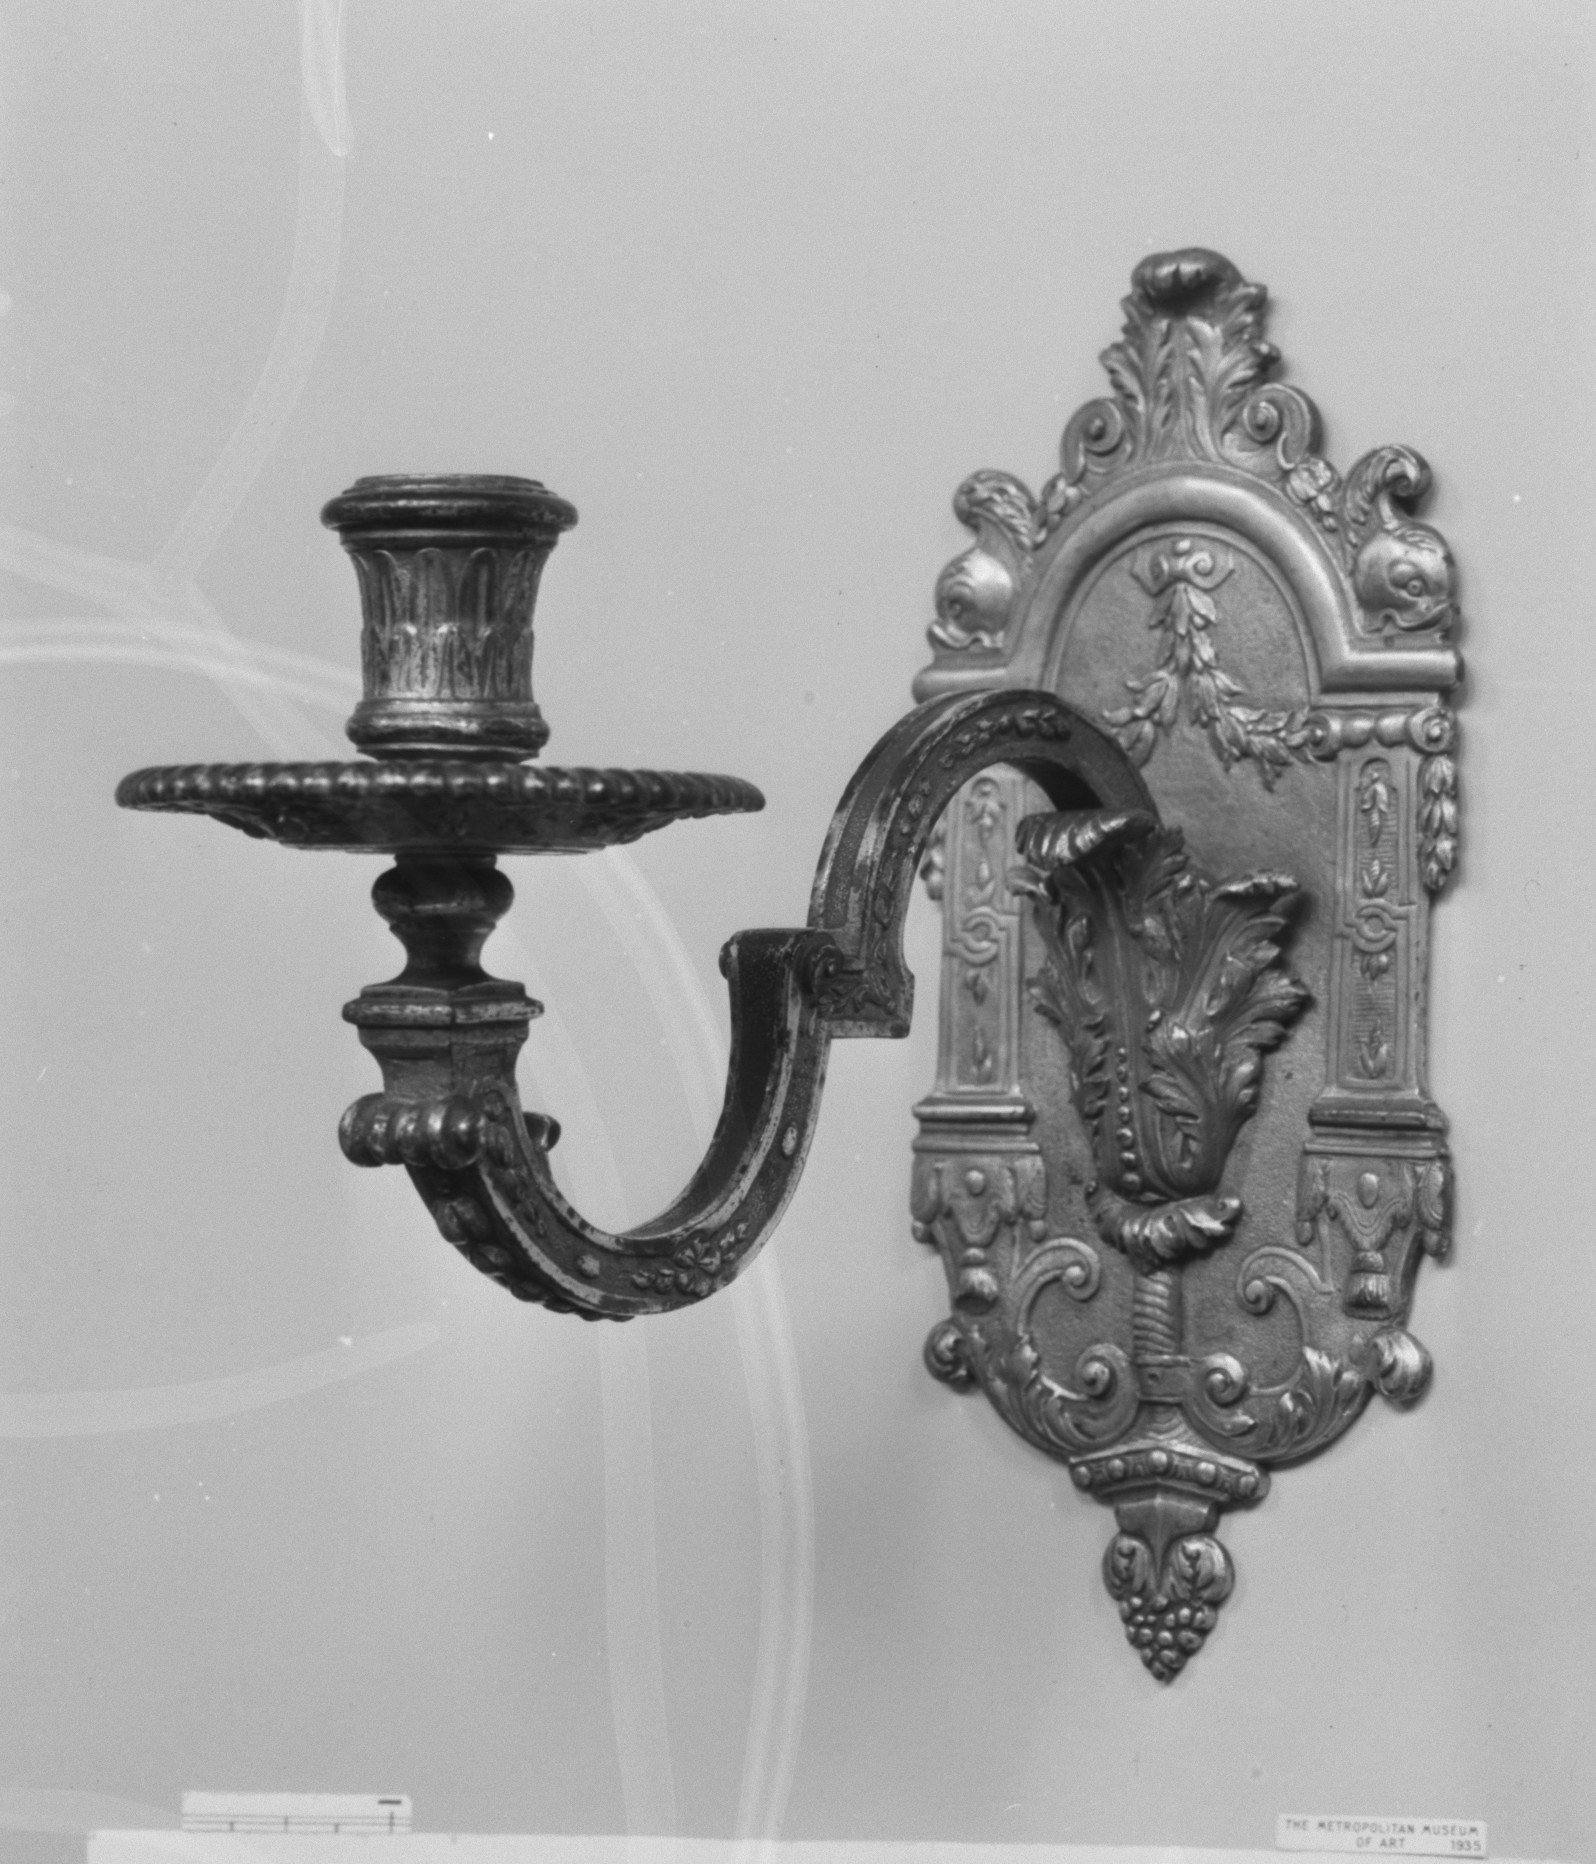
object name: wall bracket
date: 1701-1733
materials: gilt bronze